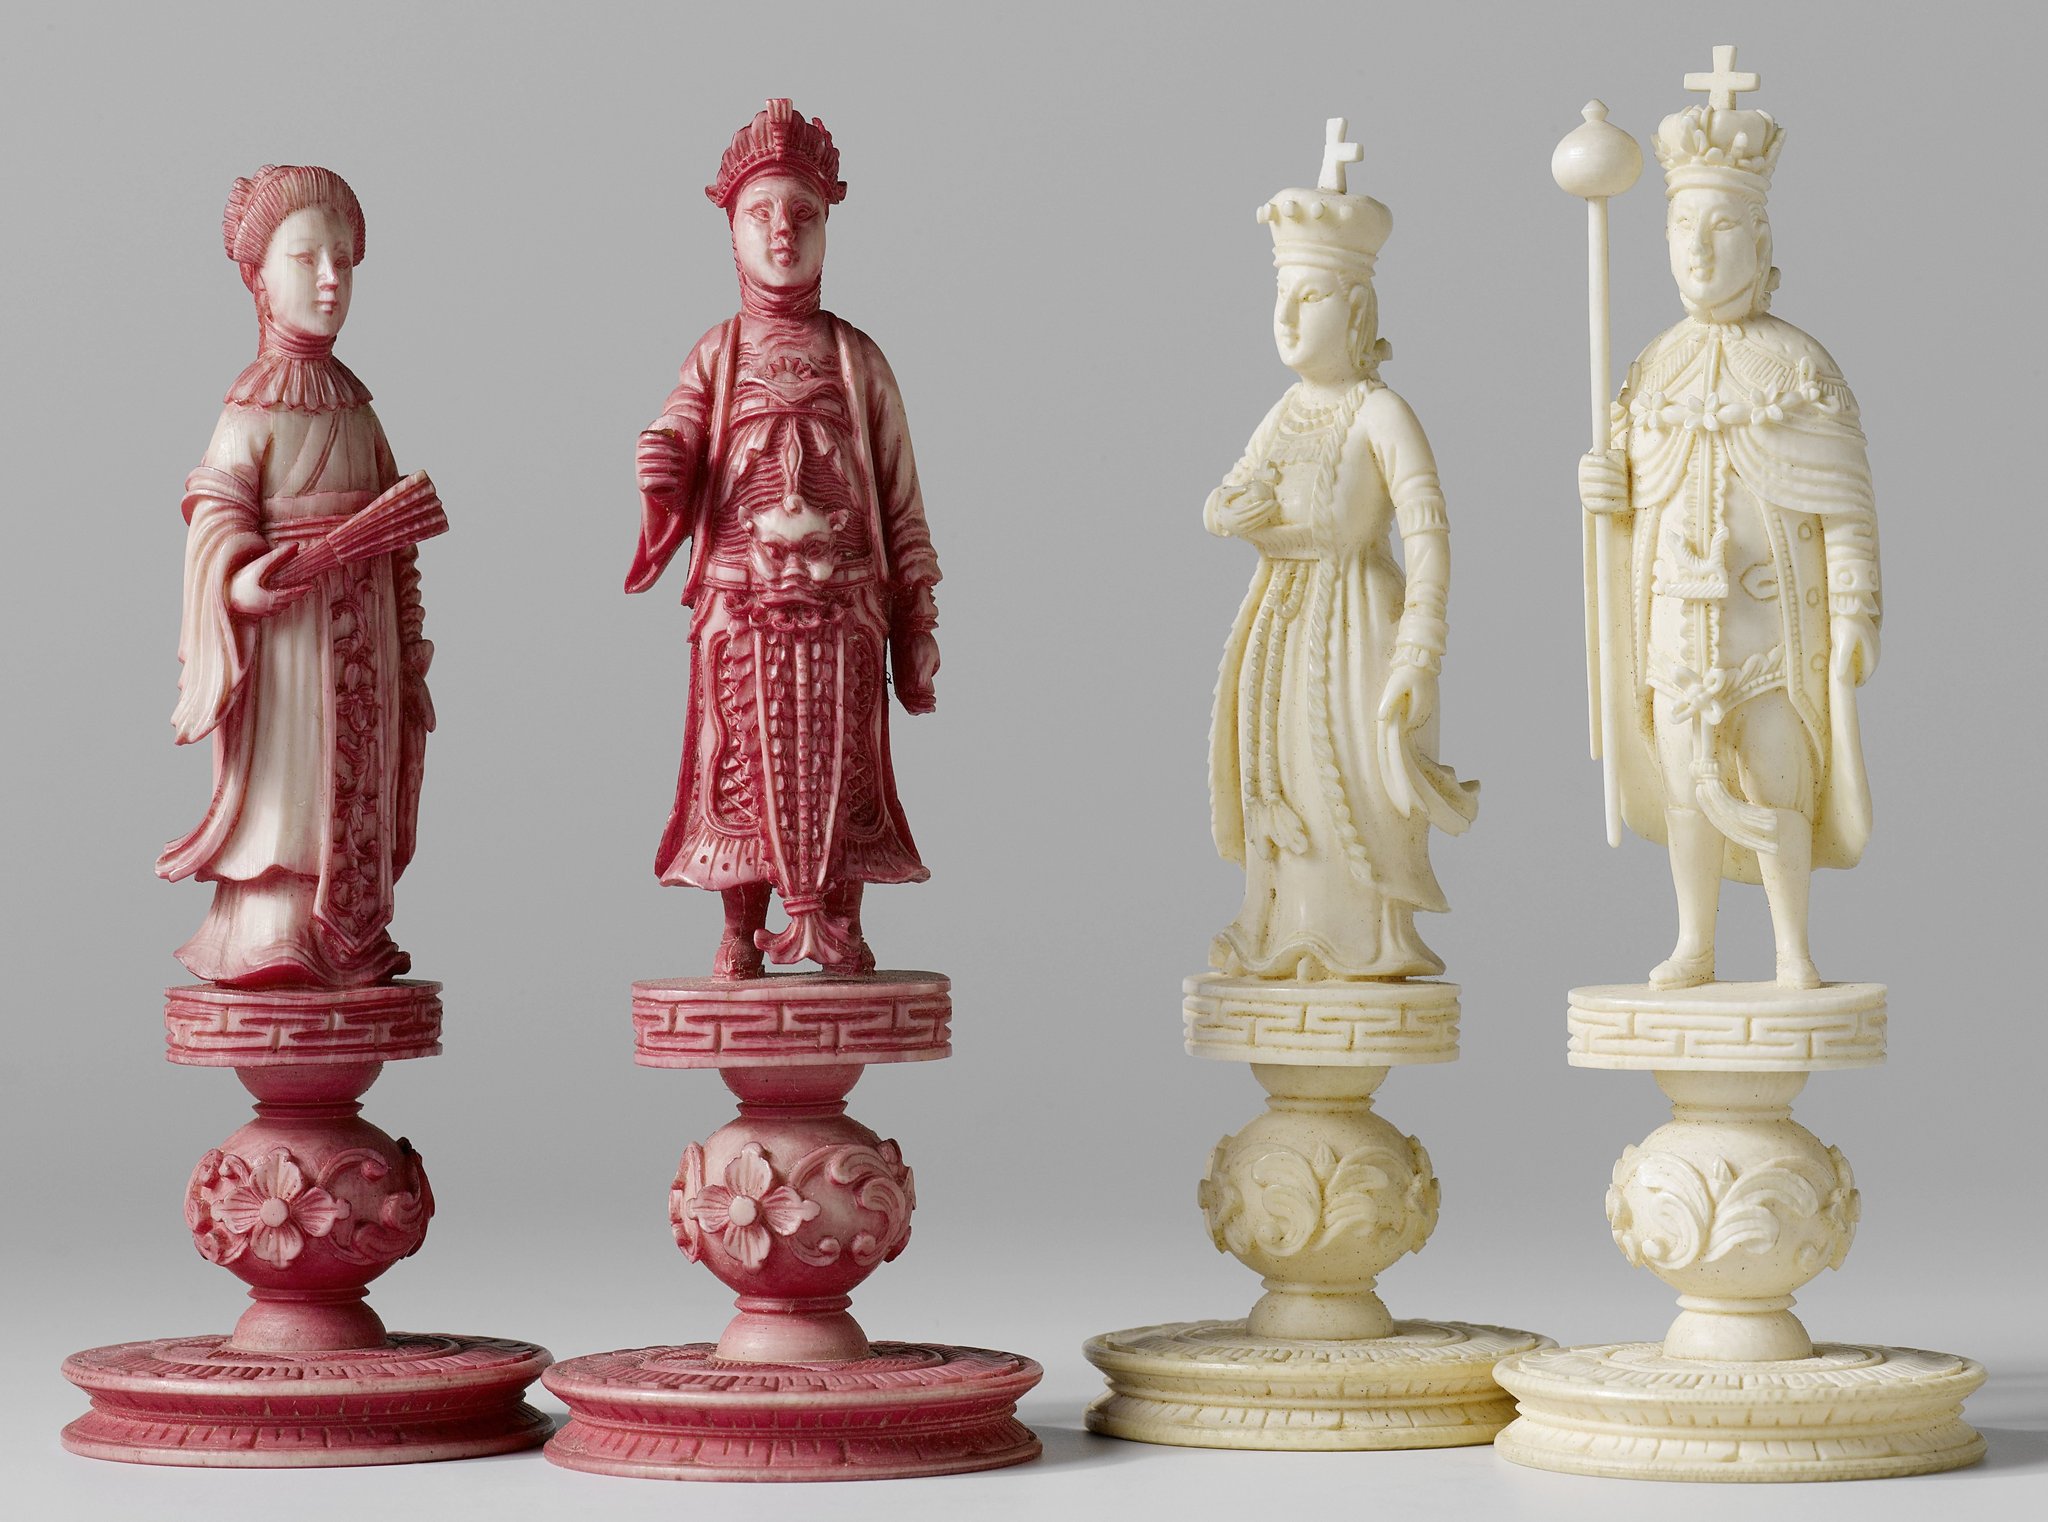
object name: chess piece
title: Schaakstukken: 32 rode en witte ivoren stukken zonder bord.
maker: Anonymous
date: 1825-1850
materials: ivory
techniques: cutting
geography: guangdong